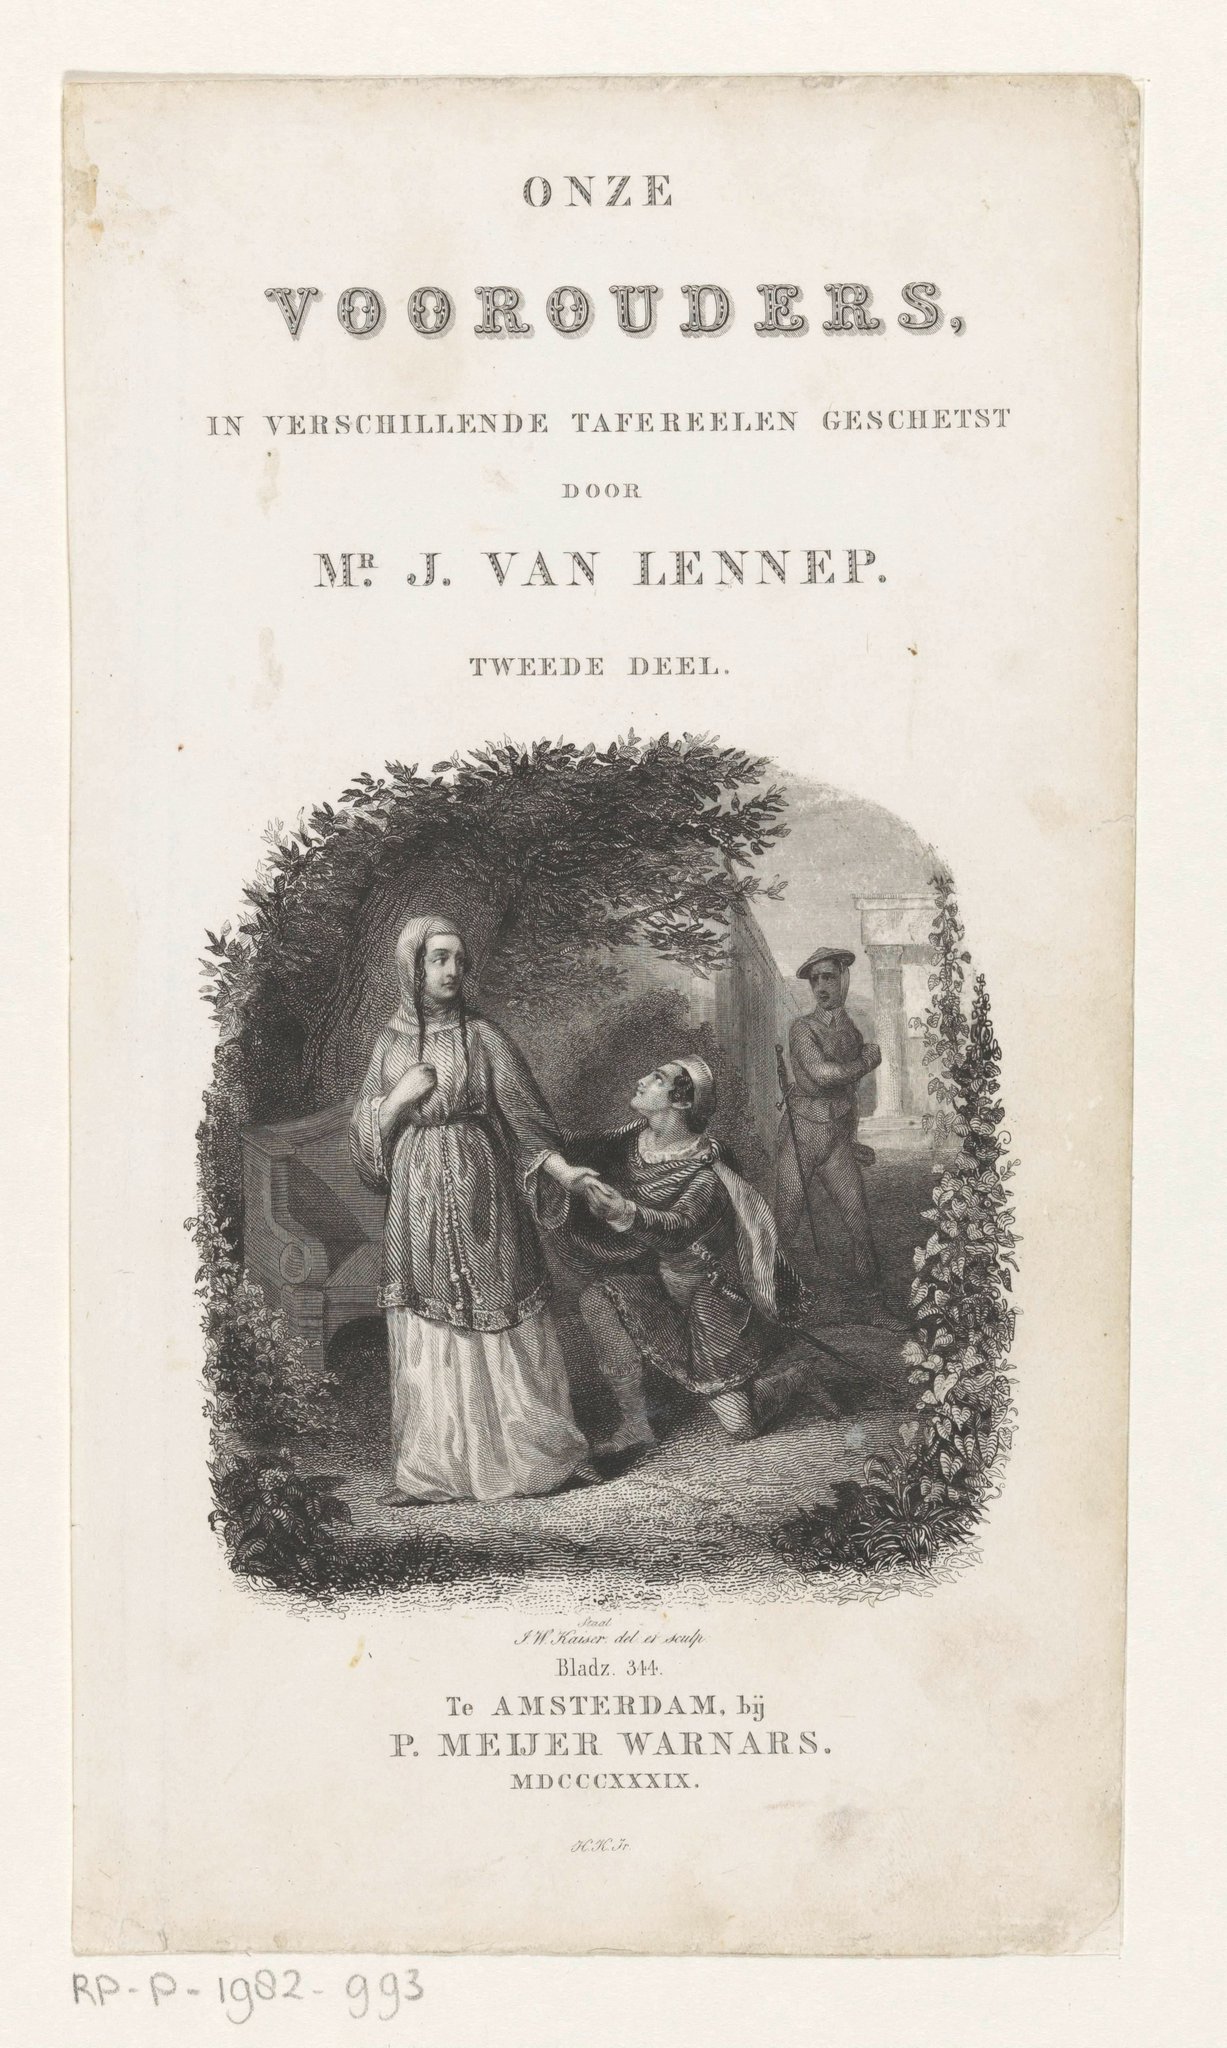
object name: print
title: Man zit knielend naast een vrouw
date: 1839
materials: paper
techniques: engraving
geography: amsterdam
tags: garden, kneeling figure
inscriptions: collector's mark: Lugt 2228, collector's mark: Lugt 2760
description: In een tuin knielt een man en kijkt omhoog naar de vrouw naast hem. Hij houdt haar hand vast. Achter hen komt een derde figuur aanlopen.